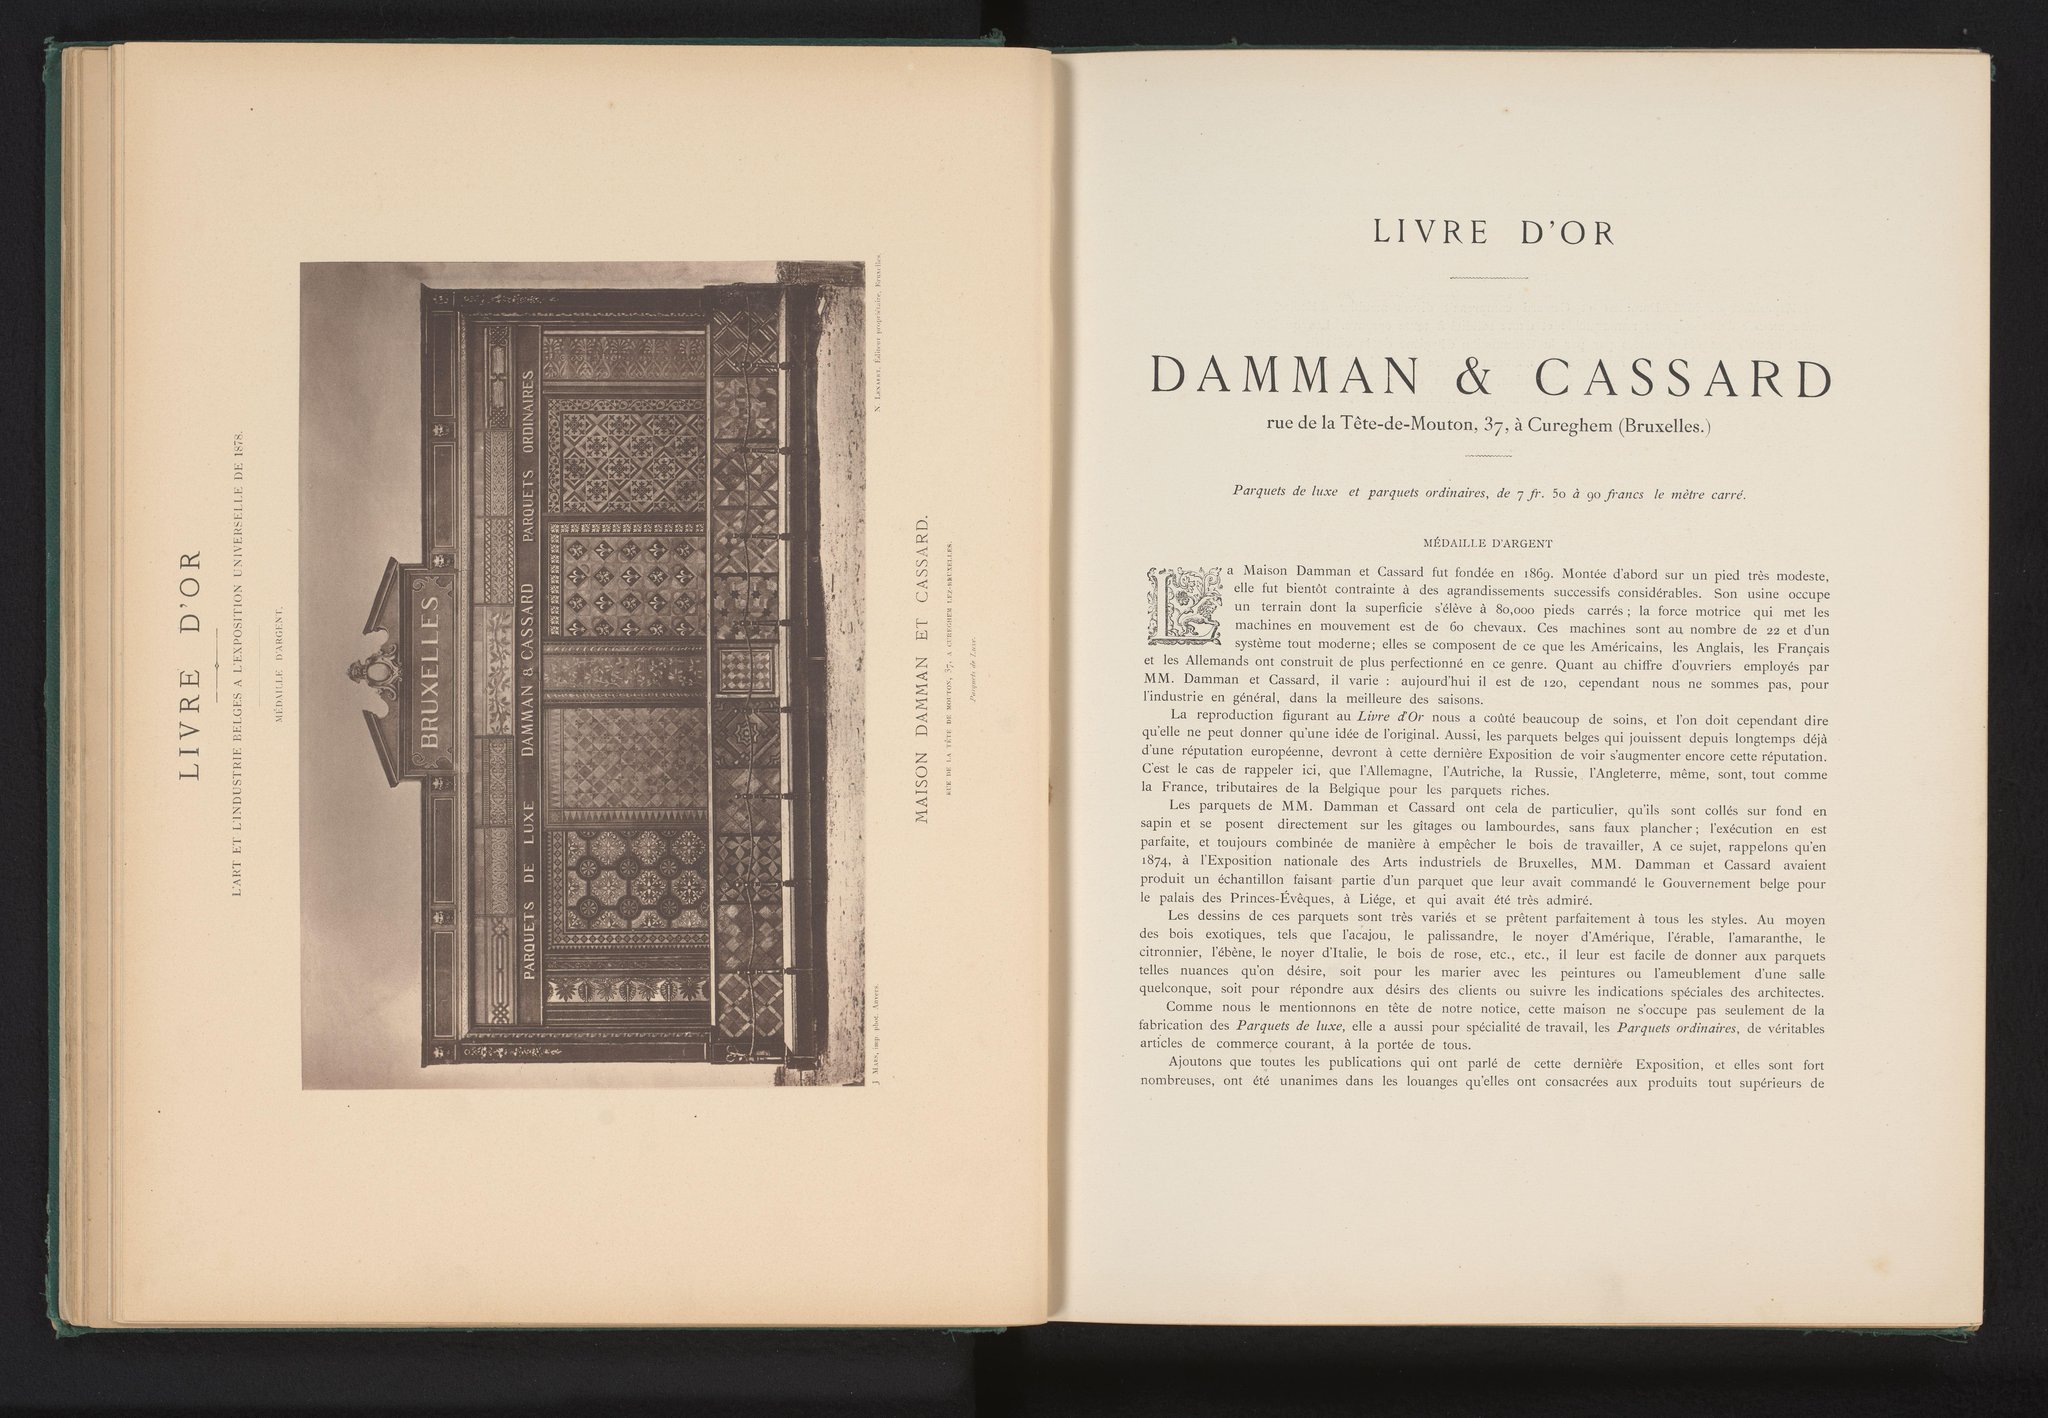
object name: page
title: Maison Damman et Cassard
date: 1874-1879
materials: paper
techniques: photograph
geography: antwerp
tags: floor-covering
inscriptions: inscription: ‘Livre d'or/ L'art et l'industrie Belges a l'exposition universelle de 1878.’, inscription: ‘Rue de la tête de mouton, 37, a Cureghem lez-Bruxelles’